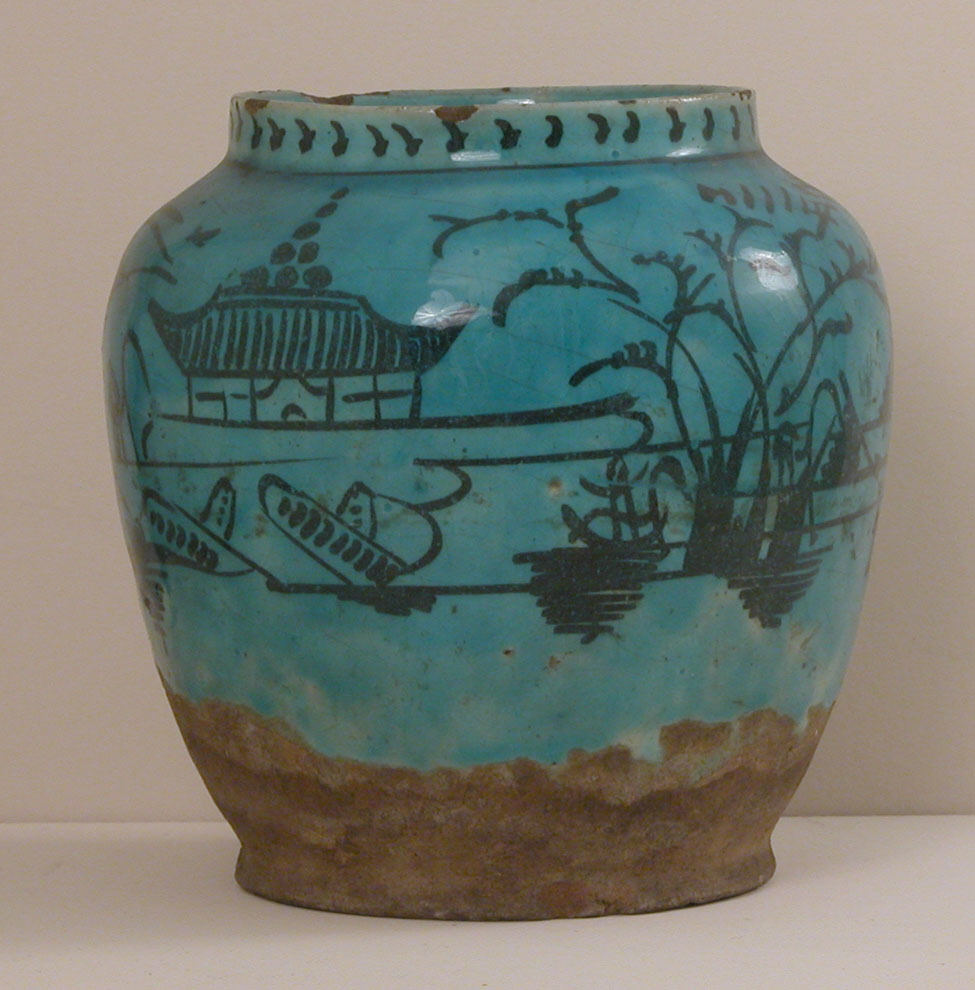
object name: jar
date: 1701-1900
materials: earthenware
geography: iran